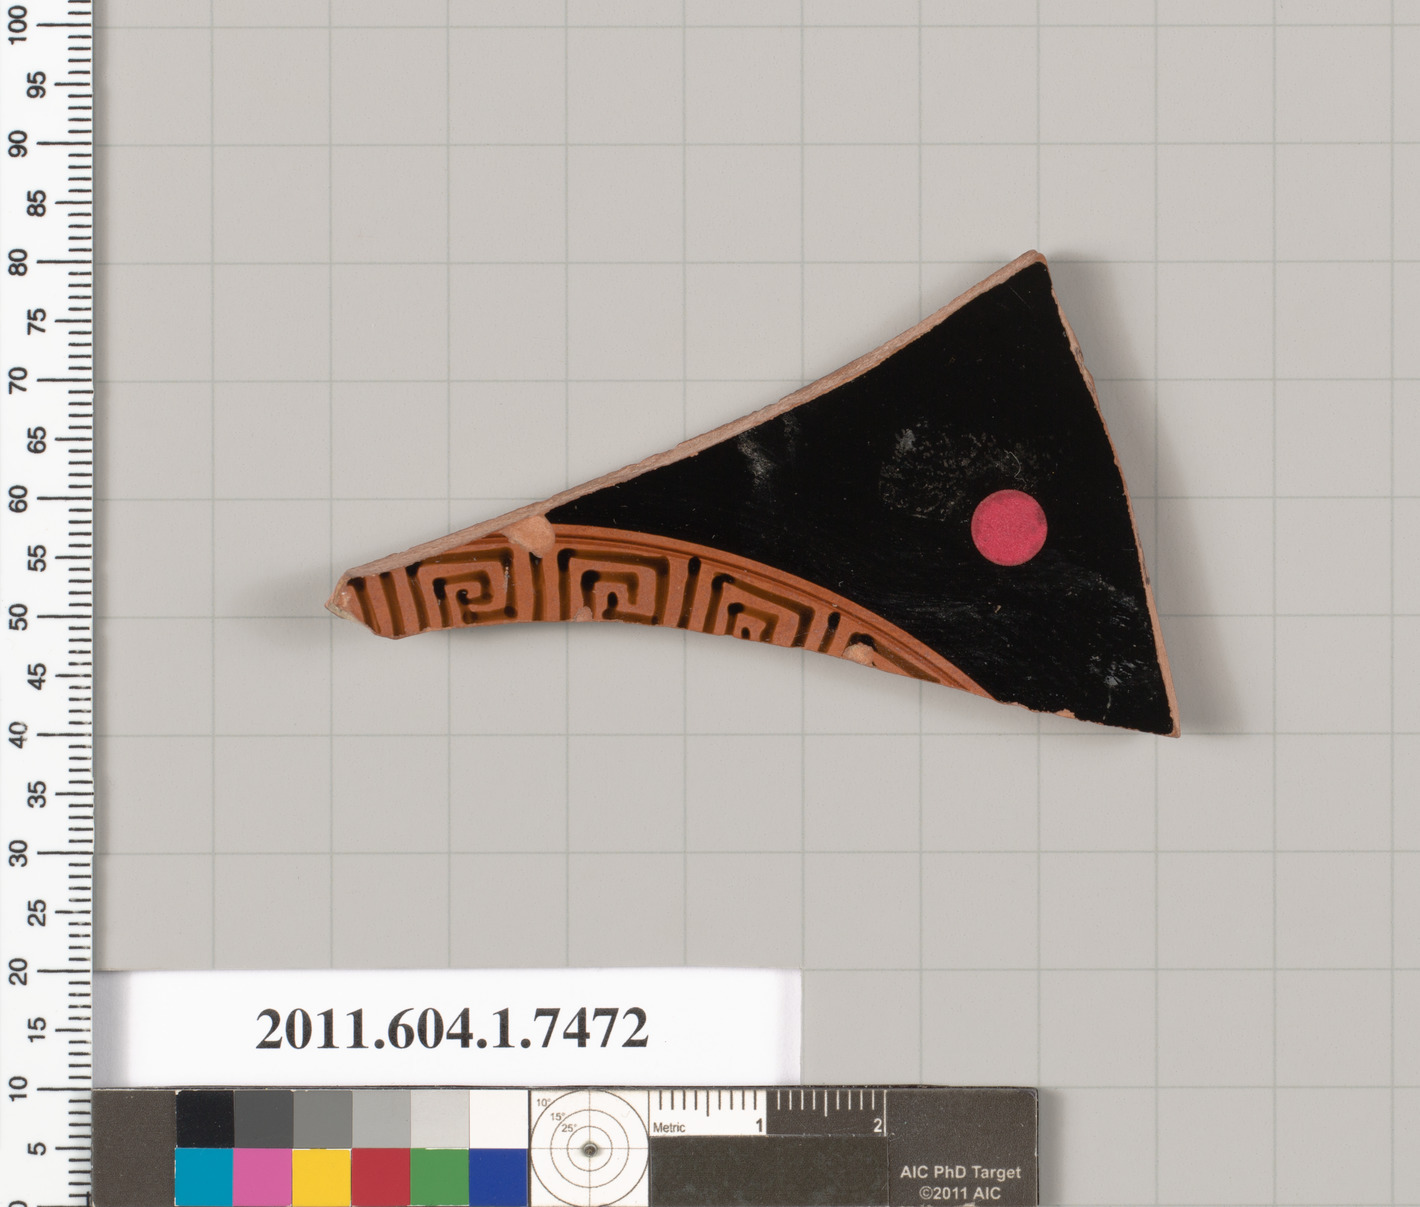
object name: kylix fragment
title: Terracotta fragment of a kylix (drinking cup)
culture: greek, attic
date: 470-460 BCE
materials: terracotta